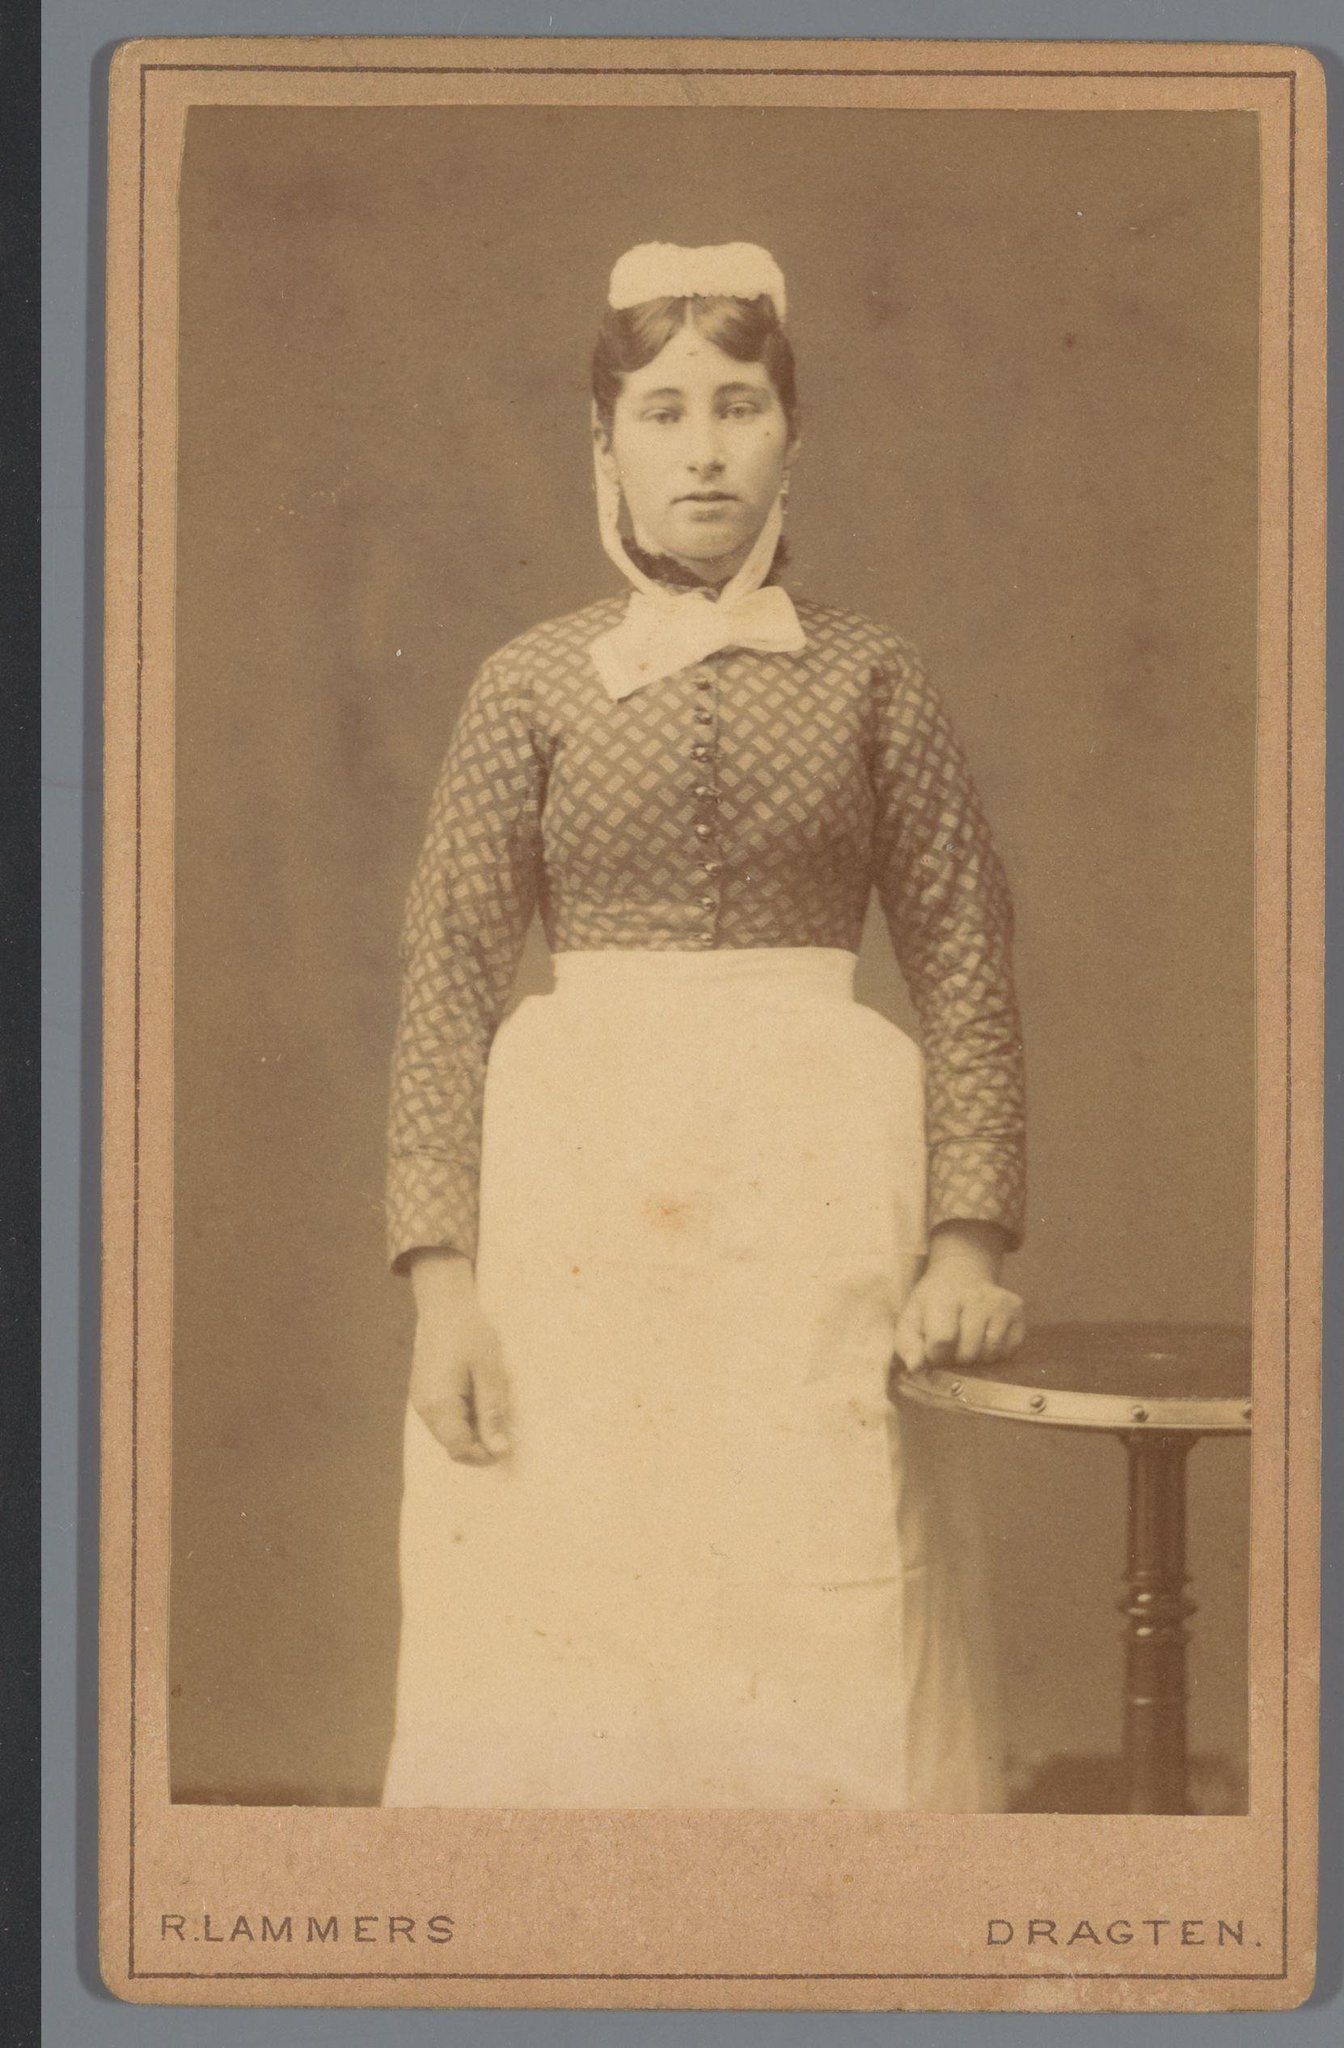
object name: carte de visite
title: Carte-de-visite Portraits of Domestic Workers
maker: roelof pieters lammers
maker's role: fotograaf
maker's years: 1853-1910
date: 1880-1910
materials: cardboard, paper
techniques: albumen print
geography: drachten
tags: adolescent, young woman, maiden, anonymous historical person portrayed, maid ~ house personnel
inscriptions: inscription: ‘R. Lammers Dragten.’, inscription: ‘Photographie/ Instantanée/ van/ R. Lammers/ Dragten.’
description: The woman in the upper left photograph is Lina Hamming, a domestic worker in Amsterdam. Hamming was one of thousands of women who worked in the households of wealthy families. We do not know the names of the other women, but we do know their occupation: domestic workers. They wore the characteristic white aprons and caps. The baskets and the dustpan and brush indicate their duties in the household.